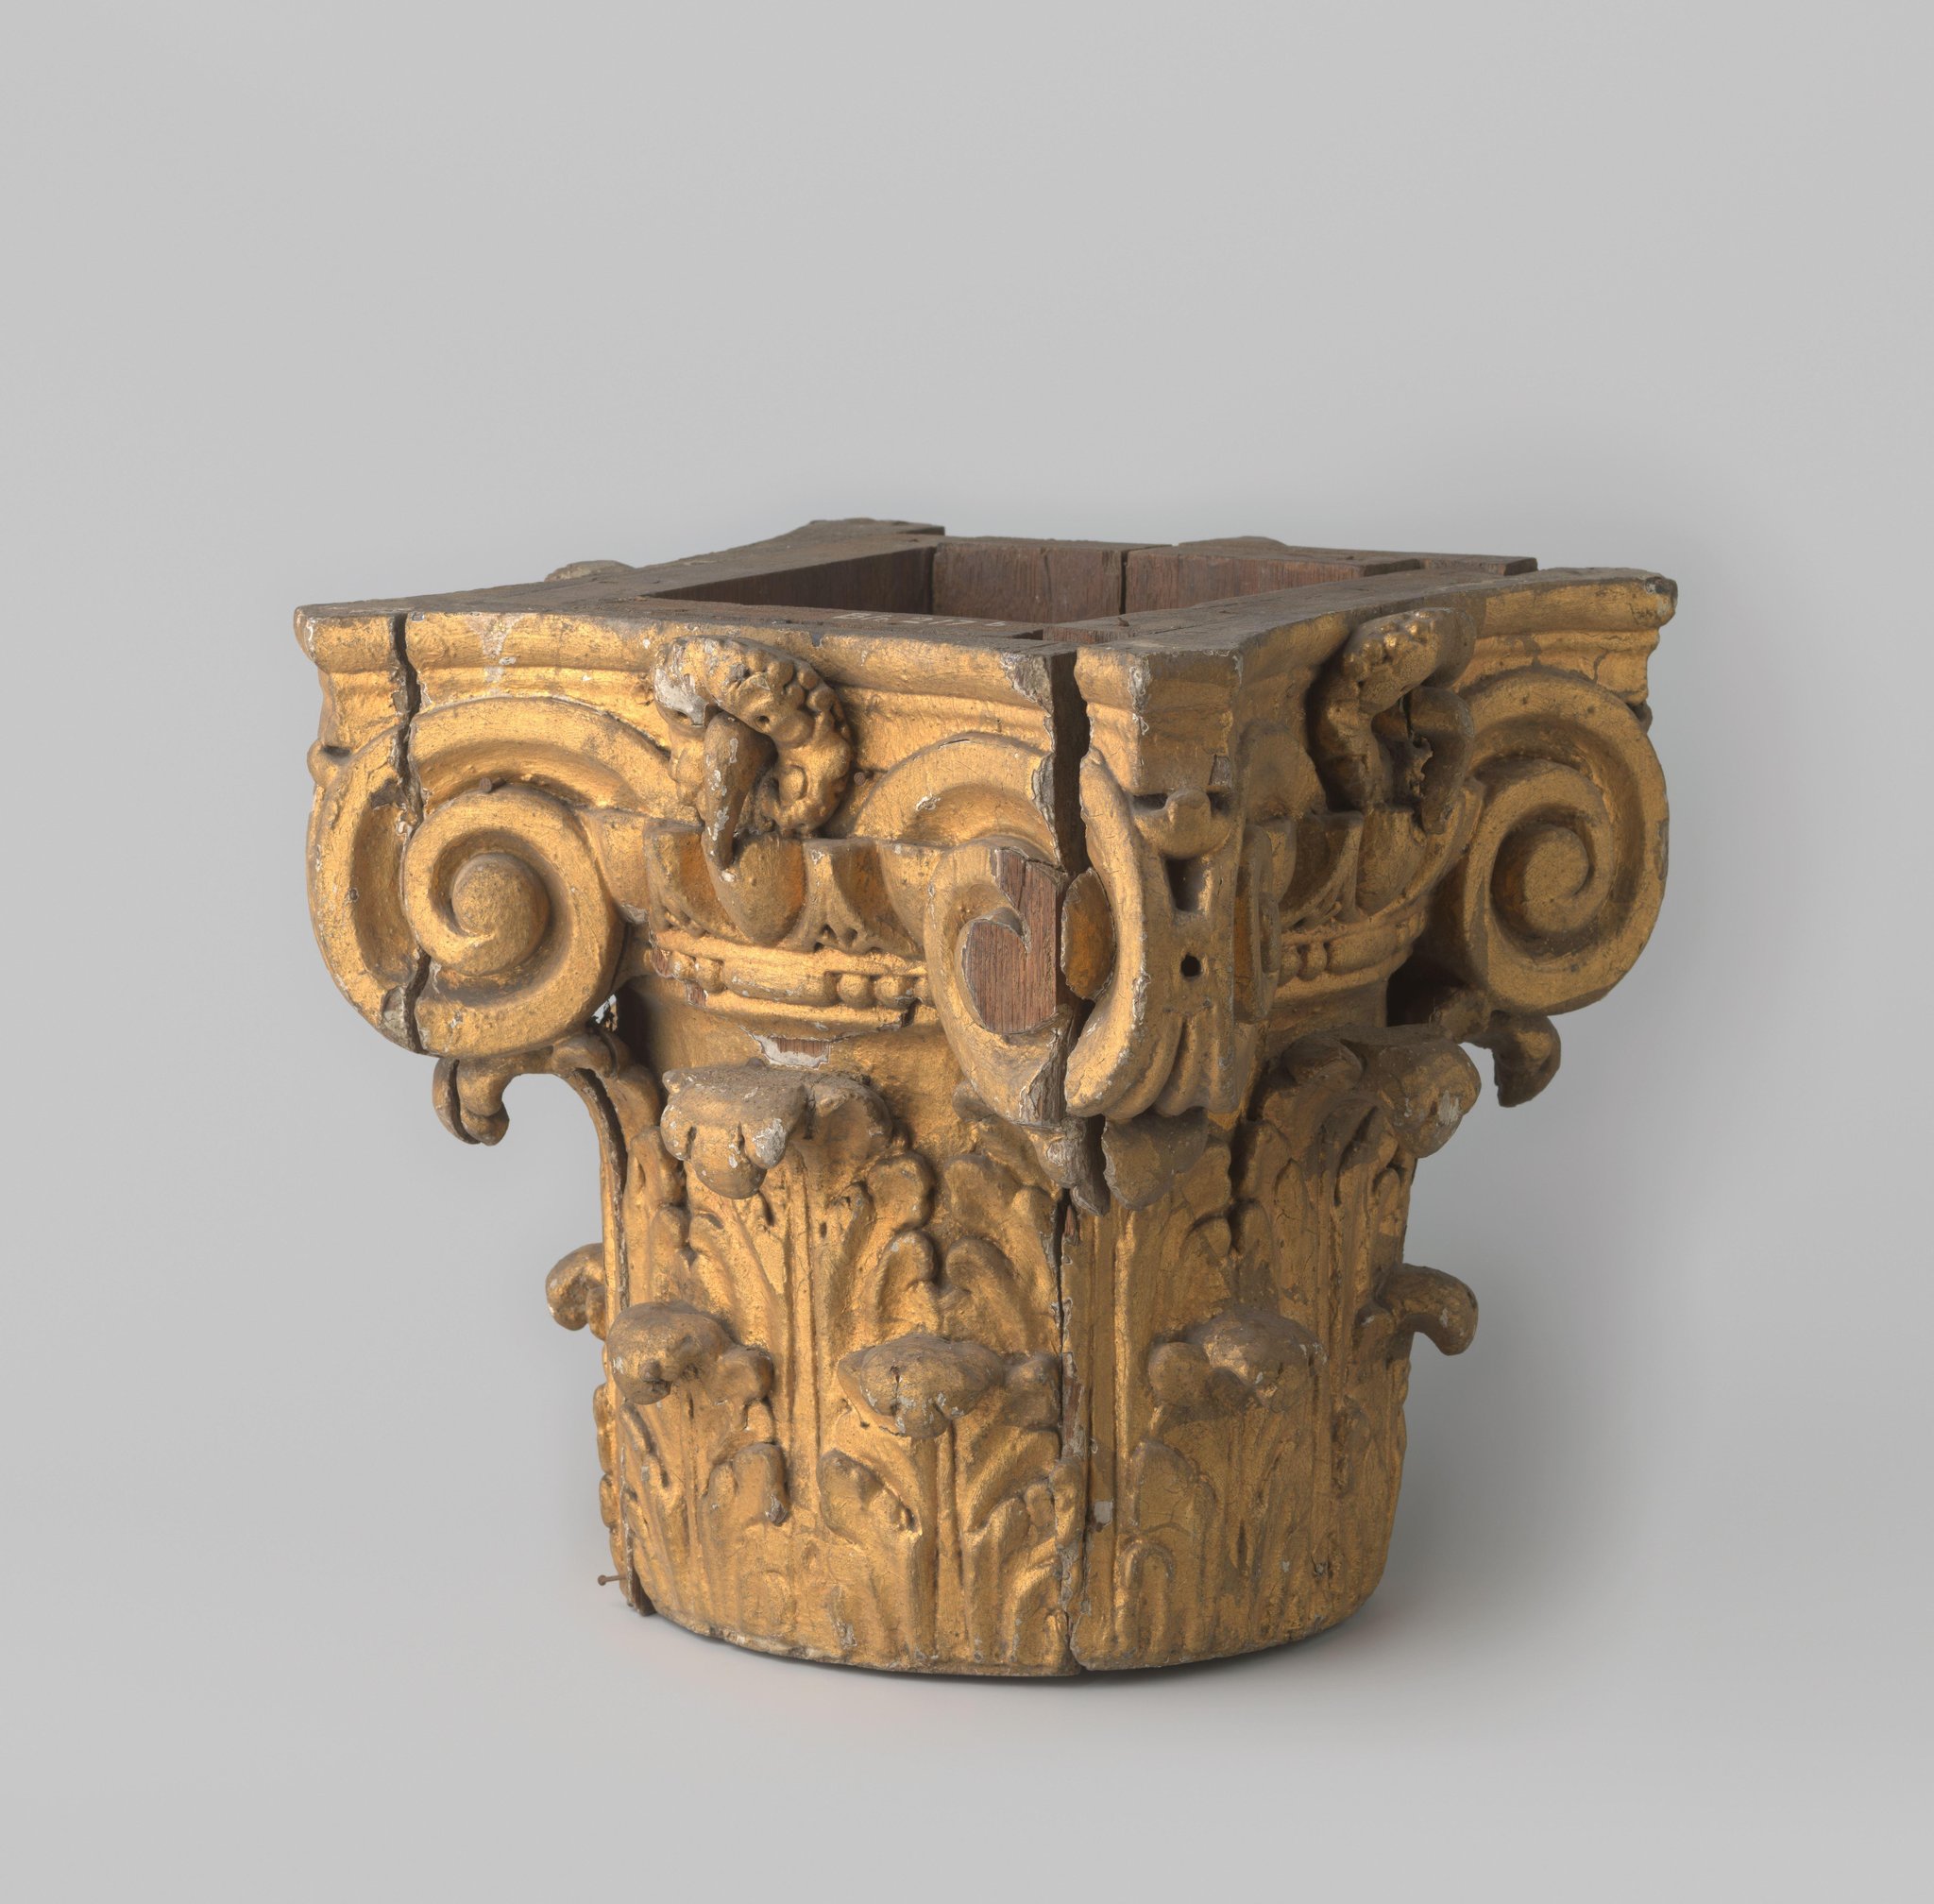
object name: architectural element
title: Kapiteel, verguld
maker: Anonymous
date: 1650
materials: wood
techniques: gilding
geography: netherlands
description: Houten gebeeldhouwd en verguld composietkapiteel.